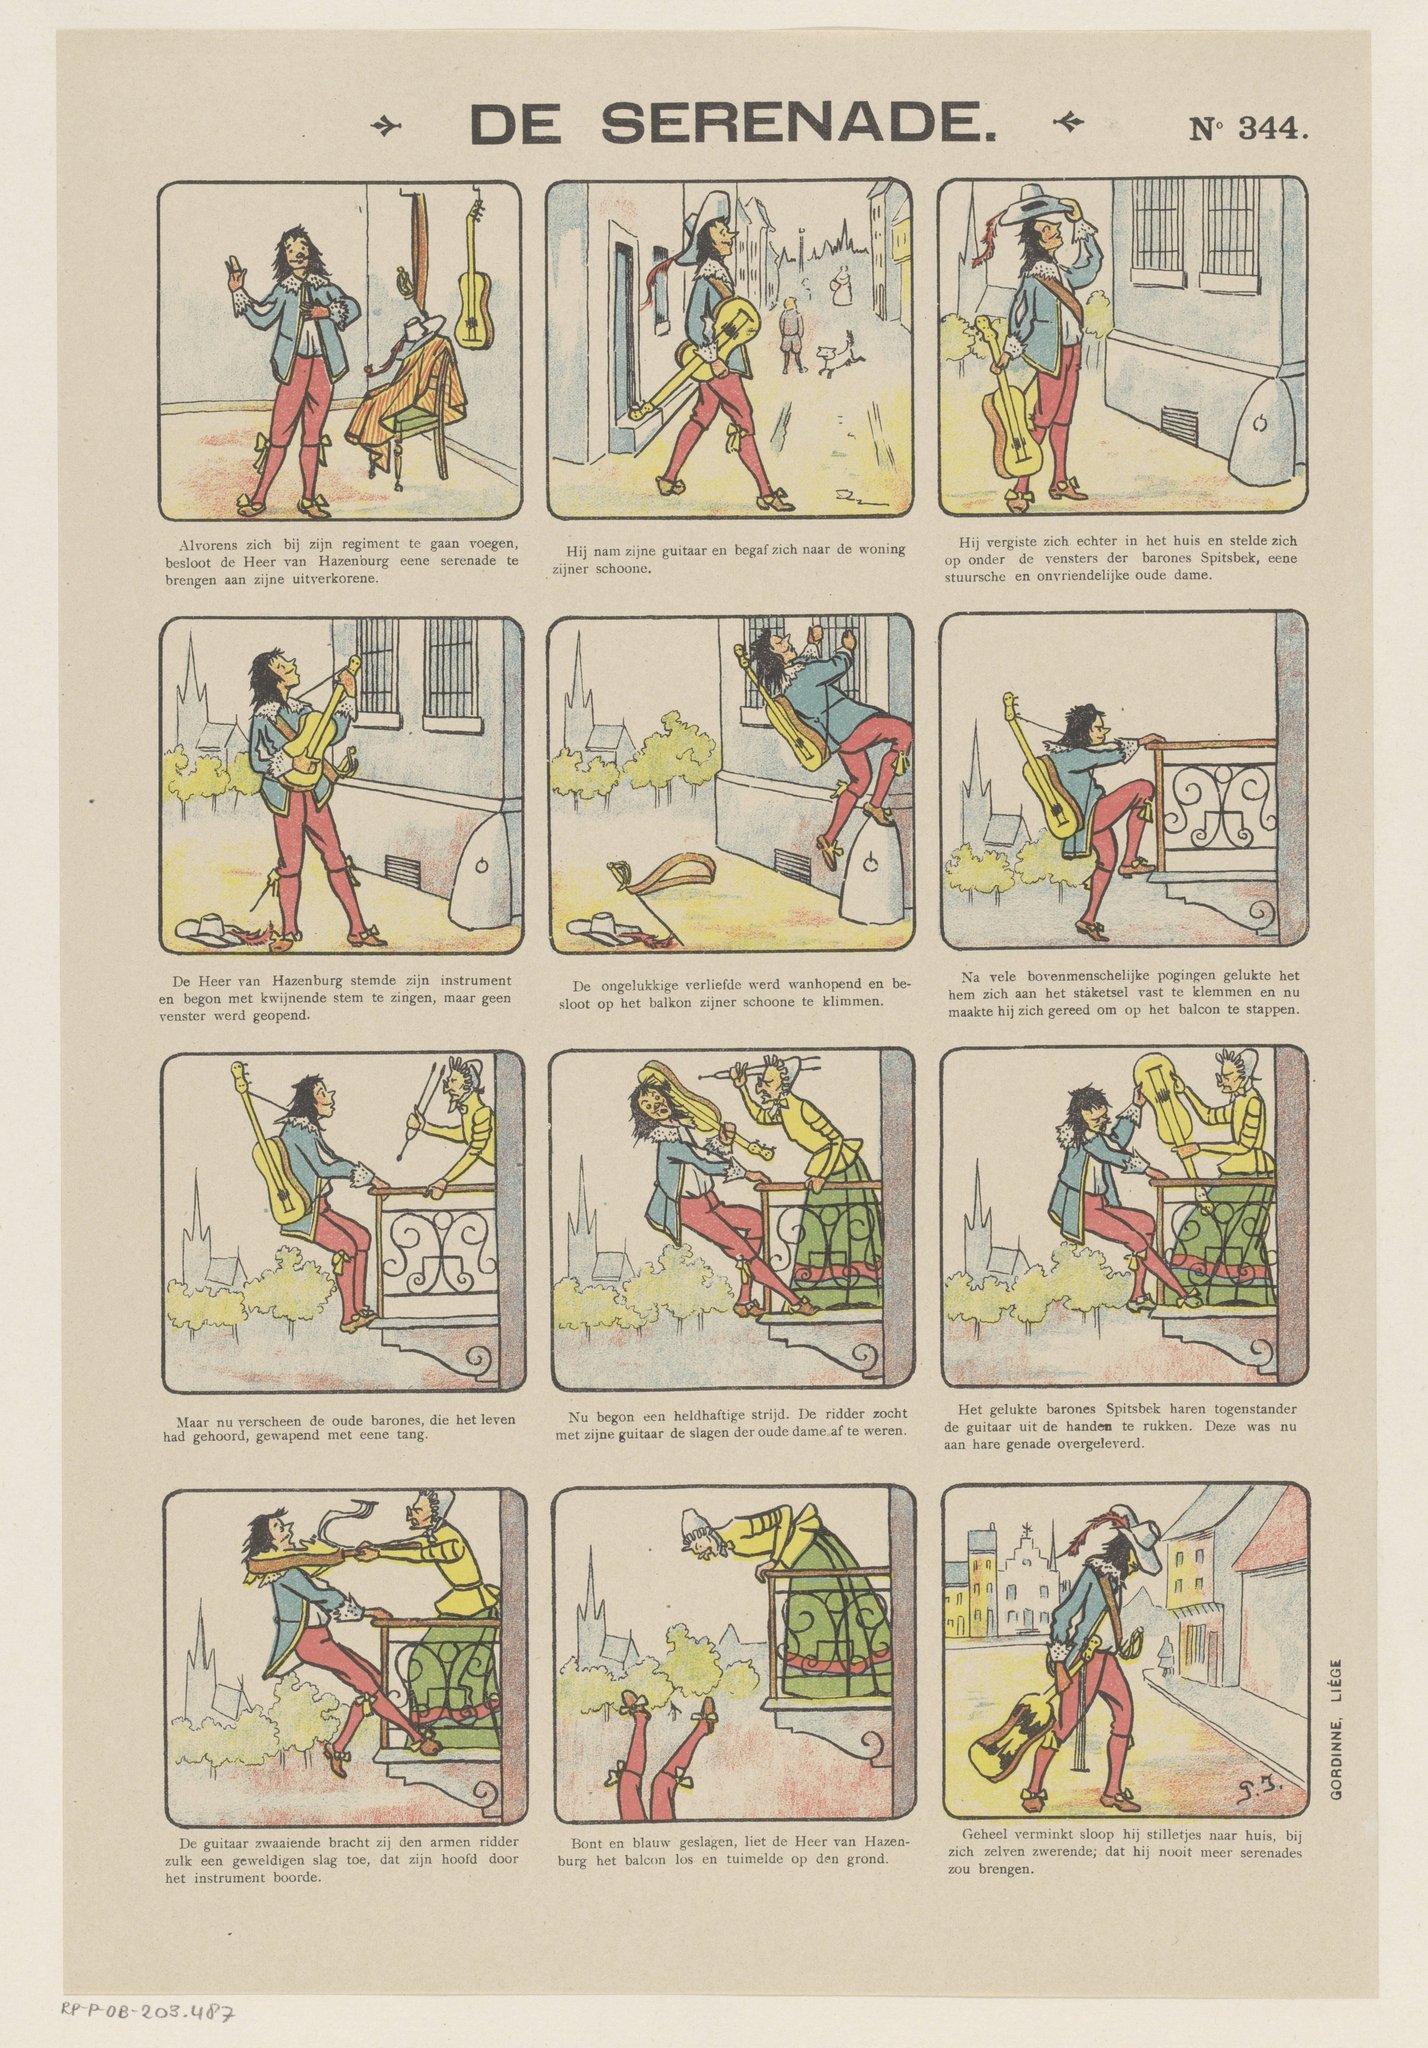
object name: popular print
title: De serenade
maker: monogrammist g.j.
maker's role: print maker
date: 1894-1959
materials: paper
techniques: lithograph, letterpress printing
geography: liège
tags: serenade to the beloved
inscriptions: collector's mark: Lugt 2760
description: Blad met 12 voorstellingen over Hannibal van Hazenburg die per ongeluk een serenade brengt onder het verkeerde balkon. Onder elke afbeelding een onderschrift. Genummerd rechtsboven: No 344.